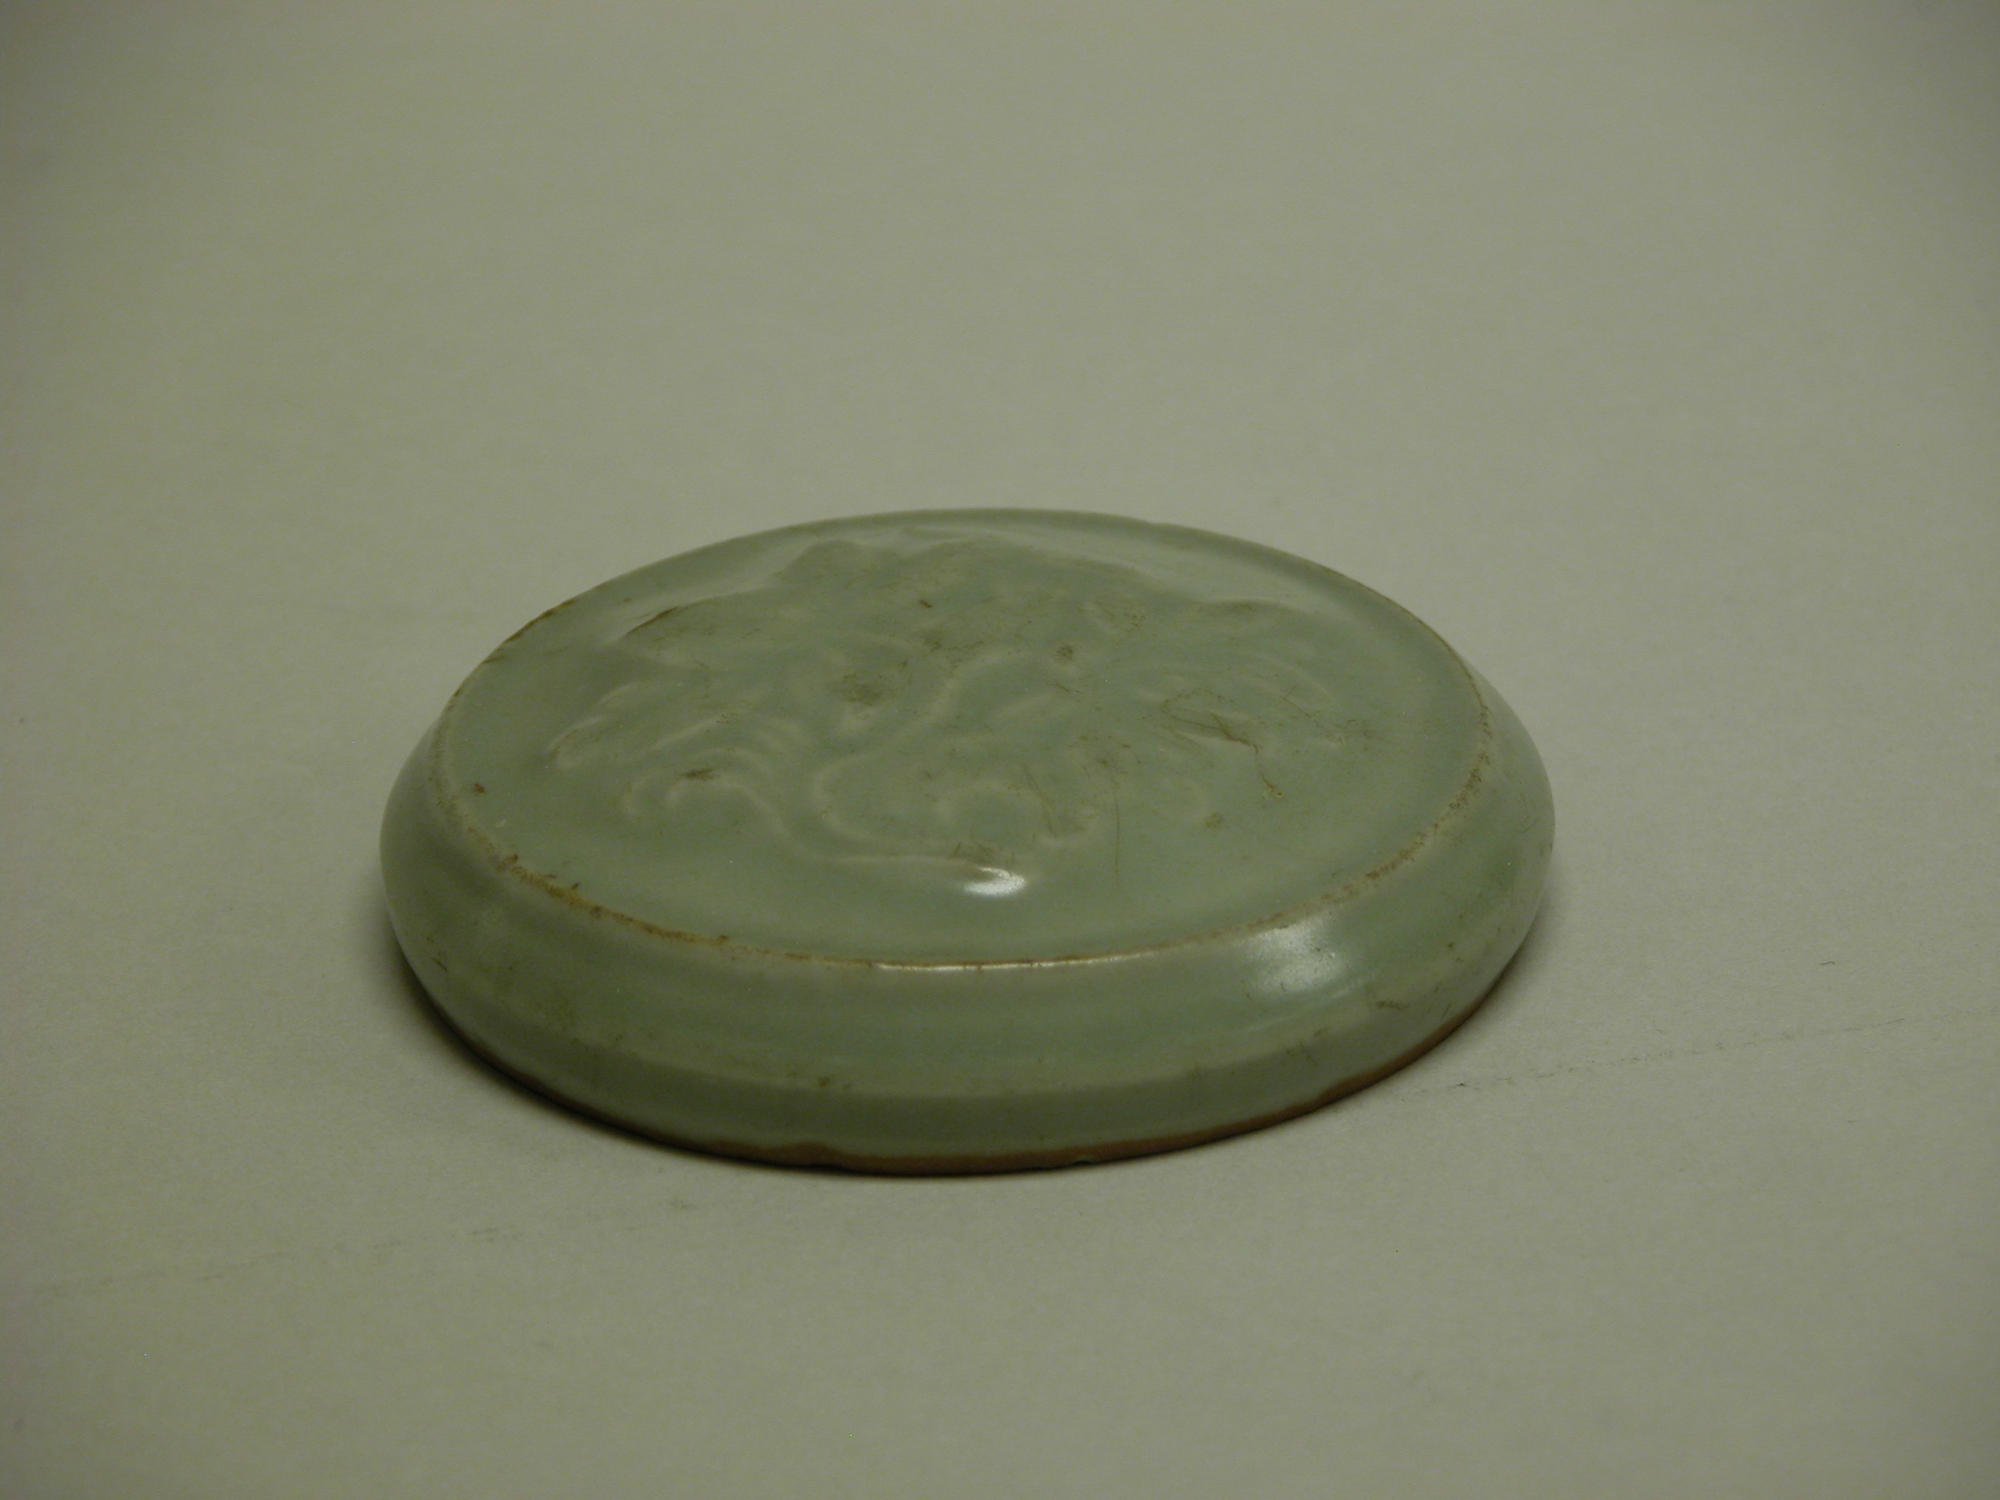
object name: box with lid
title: Lid of a box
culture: chinese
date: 1101-1300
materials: ceramic glaze, glaze, stoneware